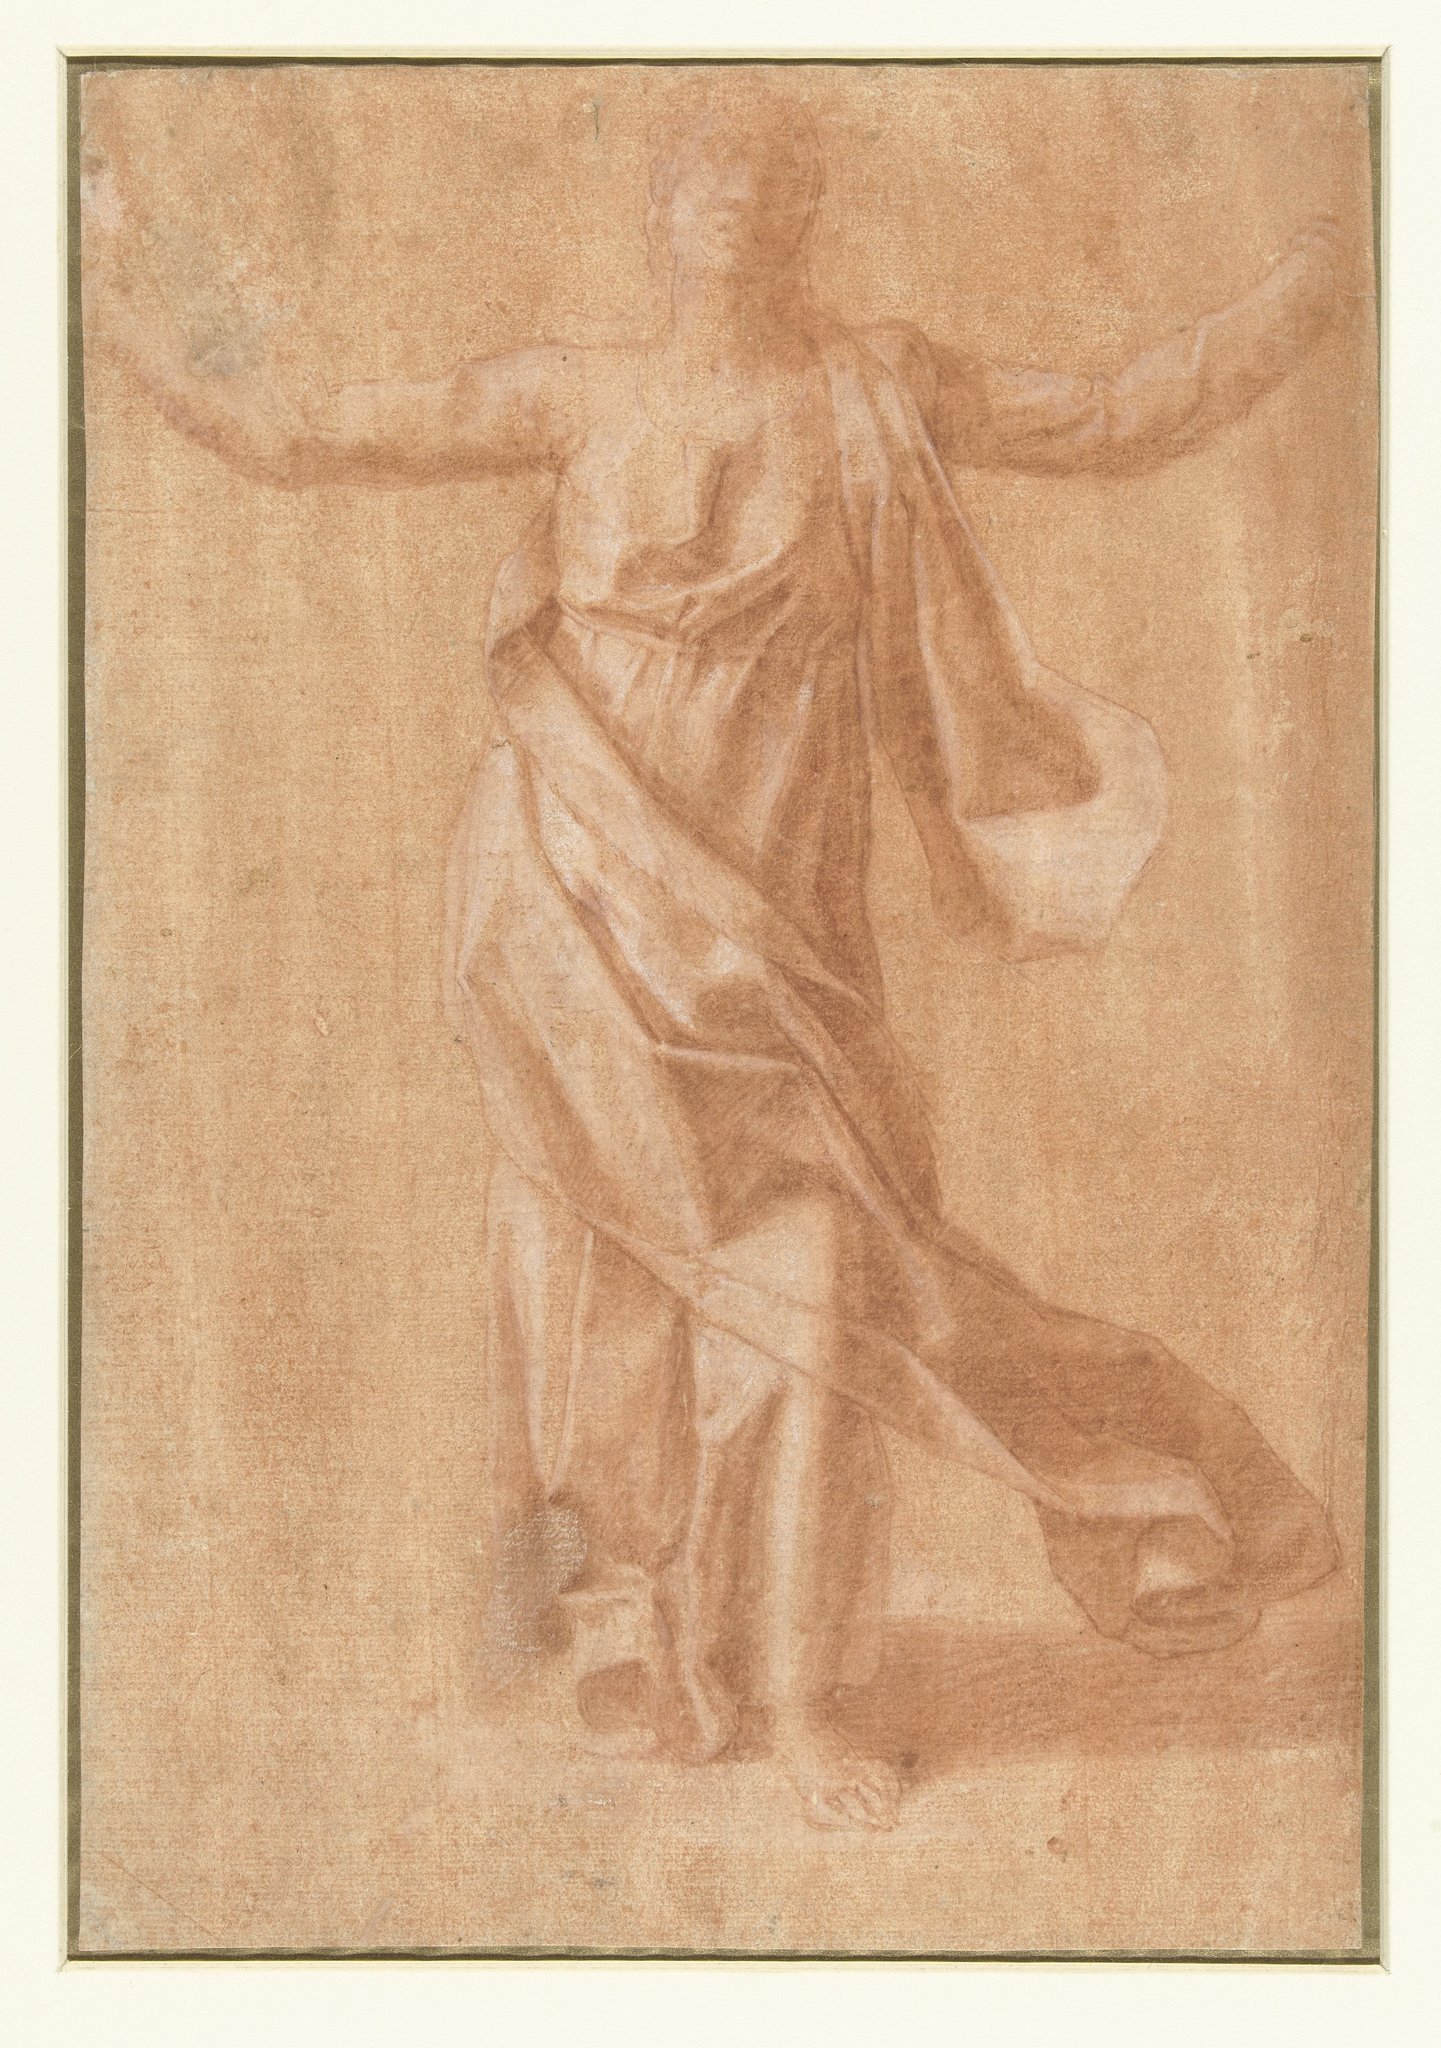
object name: drawing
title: Maria ten Hemelopneming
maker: jacopino del conte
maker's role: draughtsman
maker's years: 1510-1598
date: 1520-1598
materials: chalk, paper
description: Studie voor een Maria ten Hemelopneming.